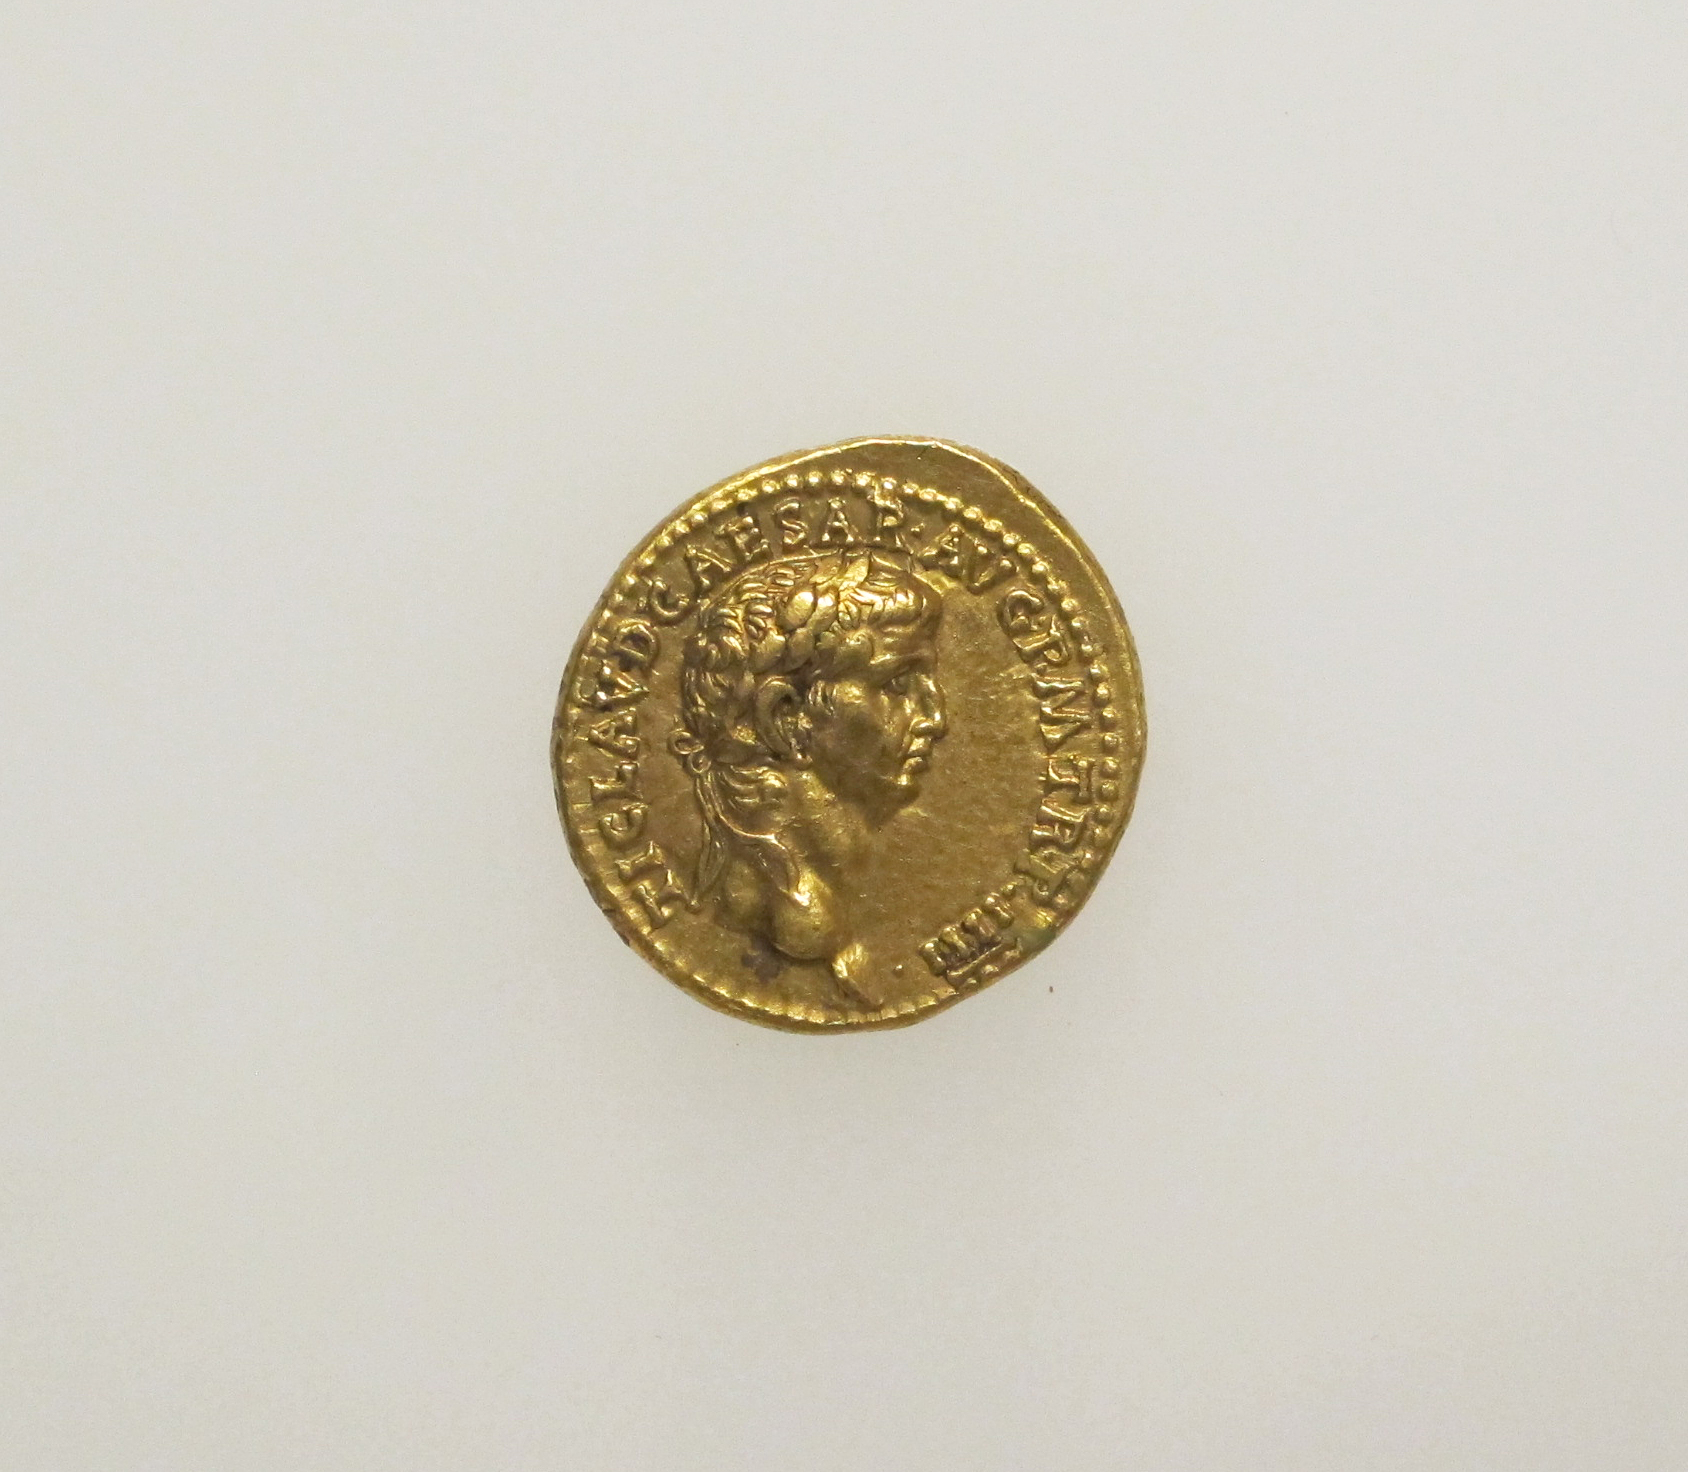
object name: aureus of claudius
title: Gold aureus of Claudius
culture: roman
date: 41-42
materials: gold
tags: profiles,coins